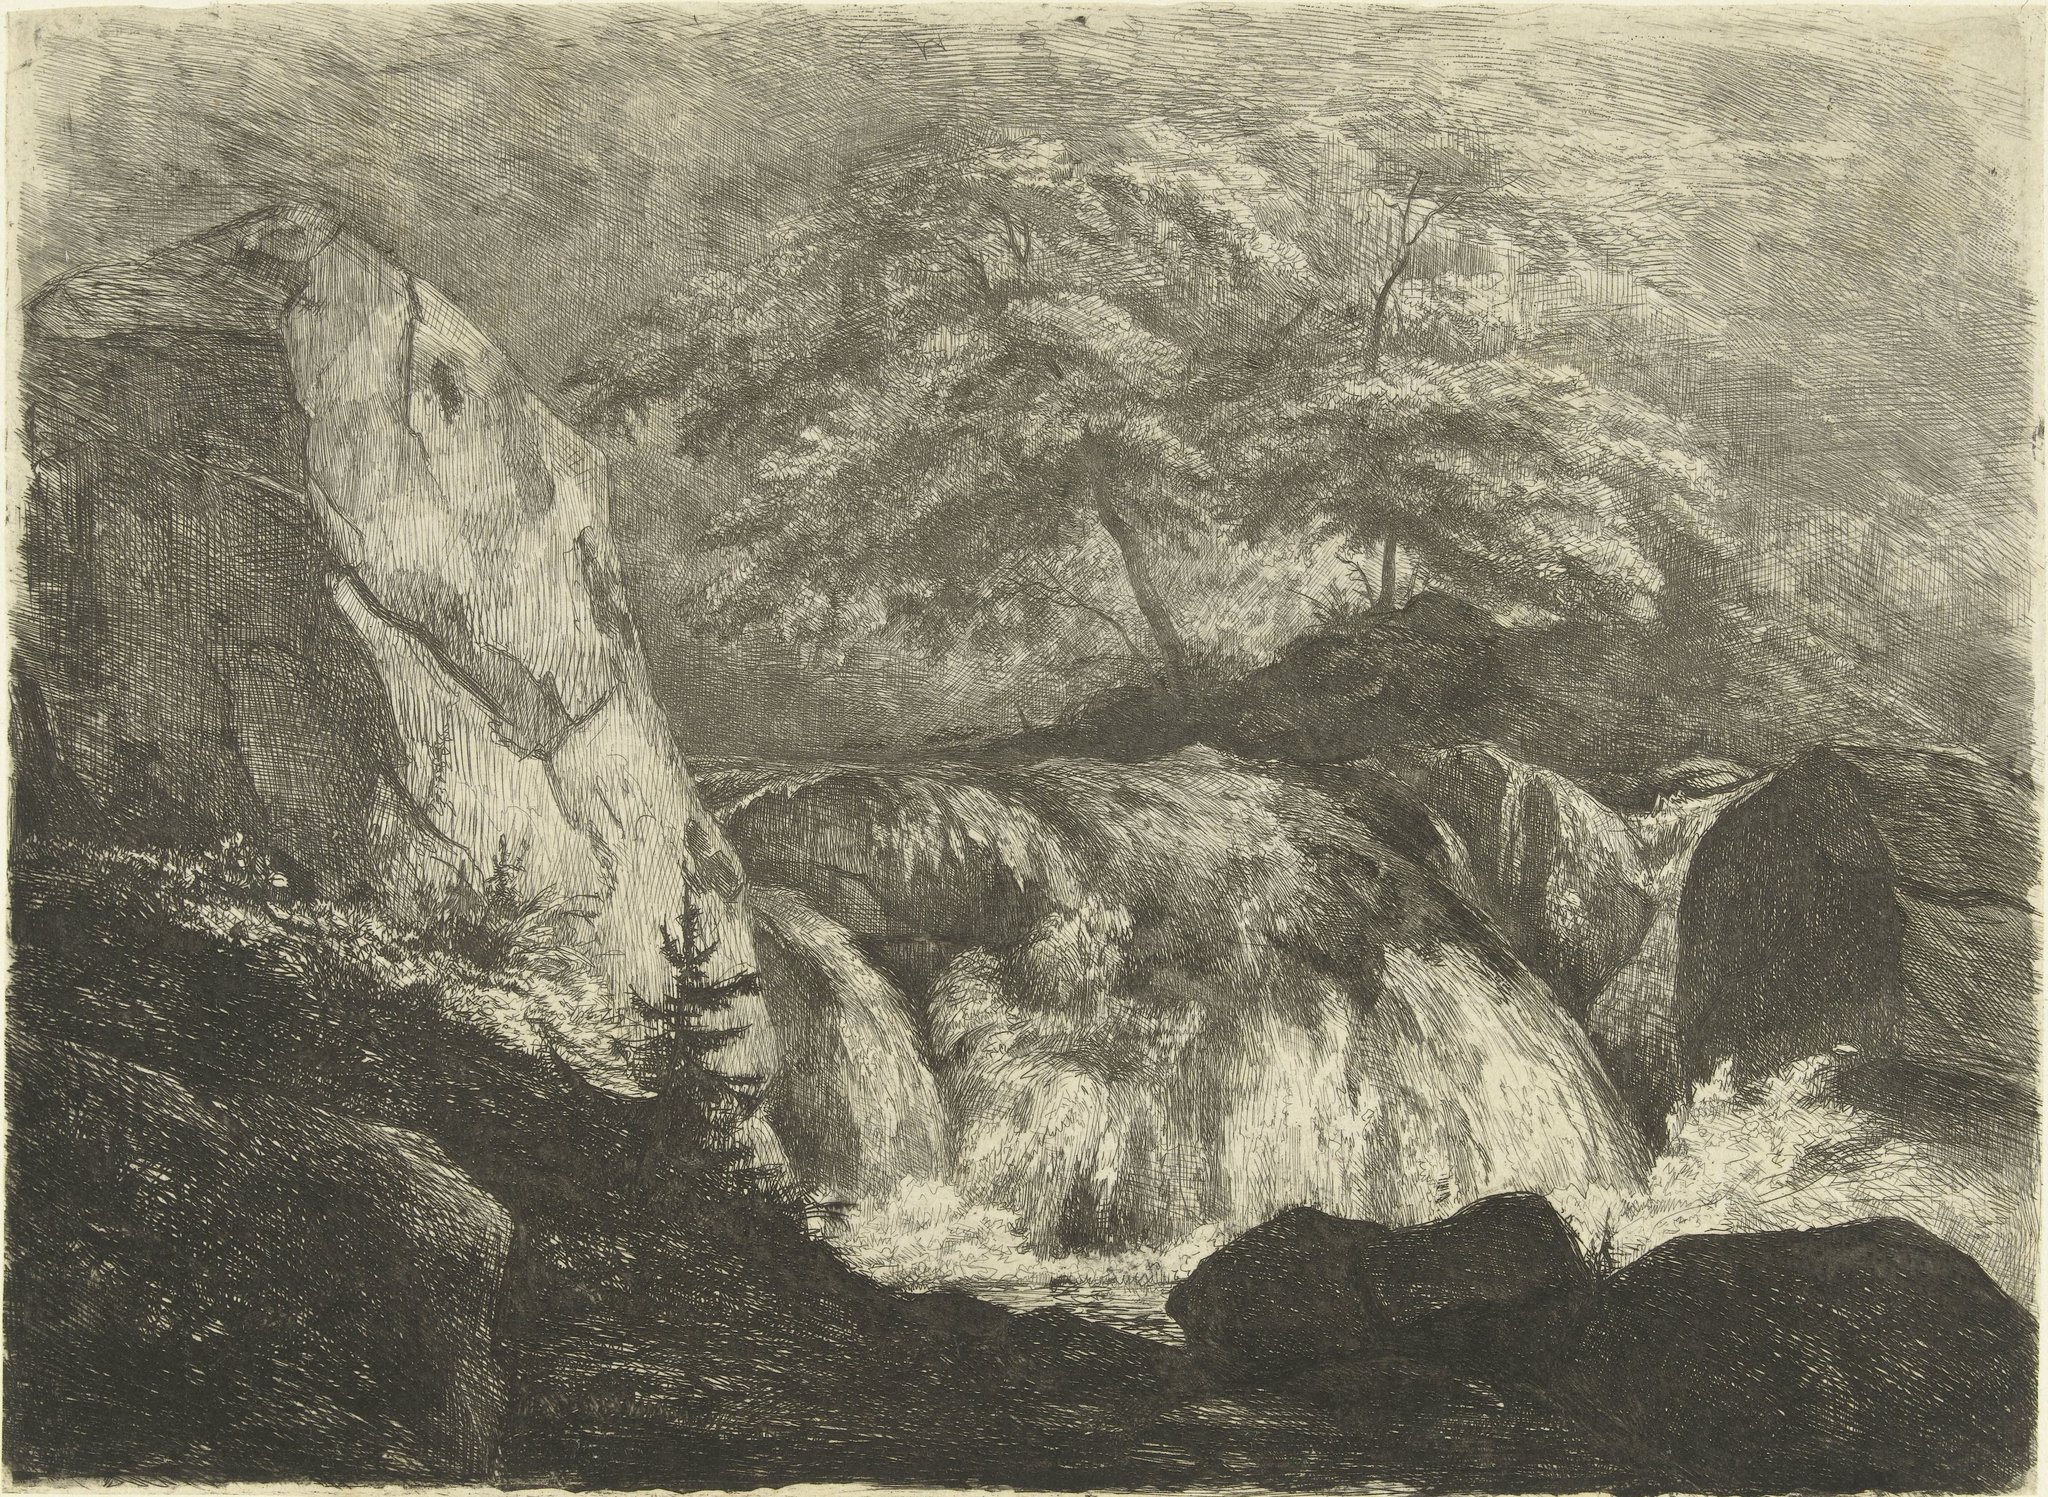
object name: print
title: Rotslandschap met waterval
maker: pierre louis dubourcq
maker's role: draughtsman, painter, print maker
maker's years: 1815-1873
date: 1830-1858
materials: paper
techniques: drypoint, etching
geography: netherlands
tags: waterfall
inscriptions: collector's mark: Lugt 2228, collector's mark: Lugt 2760